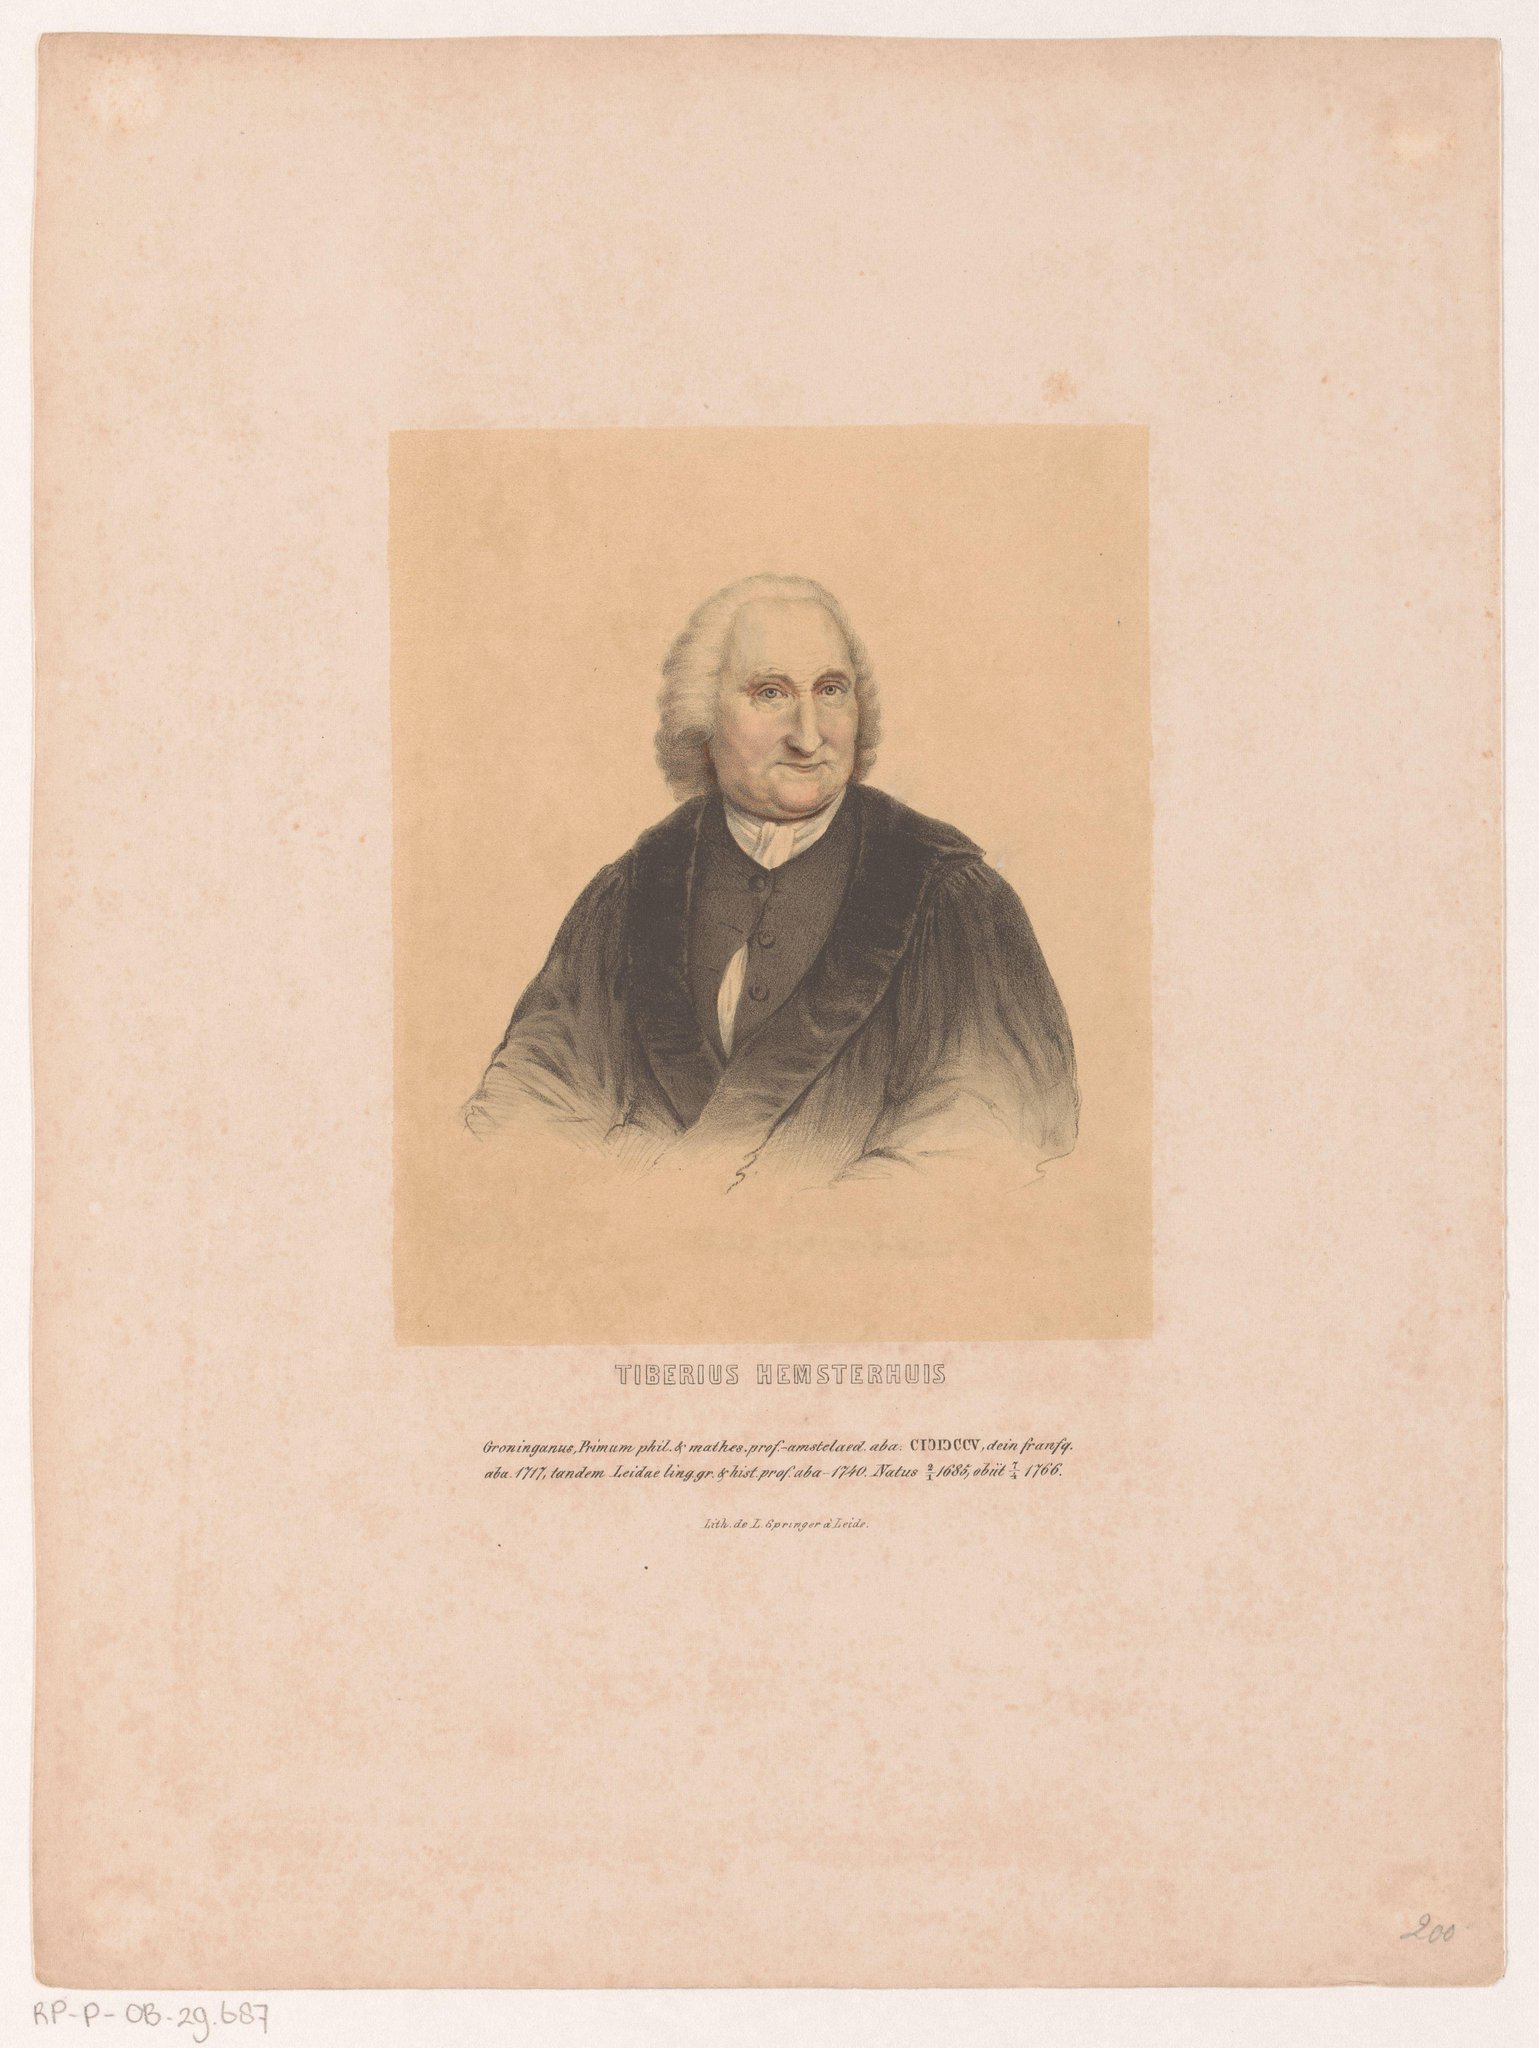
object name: print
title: Tiberius Hemsterhuis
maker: leendert springer (i)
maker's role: draughtsman, painter, print maker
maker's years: 1789-1871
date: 1850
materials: paper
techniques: lithograph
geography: leiden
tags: historical persons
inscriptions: collector's mark: Lugt 2228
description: Prent uit: Springer, Leendert. Galerij van hoogleeraren aan de Hoogeschool te Leijden, naar de oorspronkelijke afbeeldsels op de Senaat-zaal aldaar berustende. Leiden: Springer, Leendert., s.a. [circa 1850].